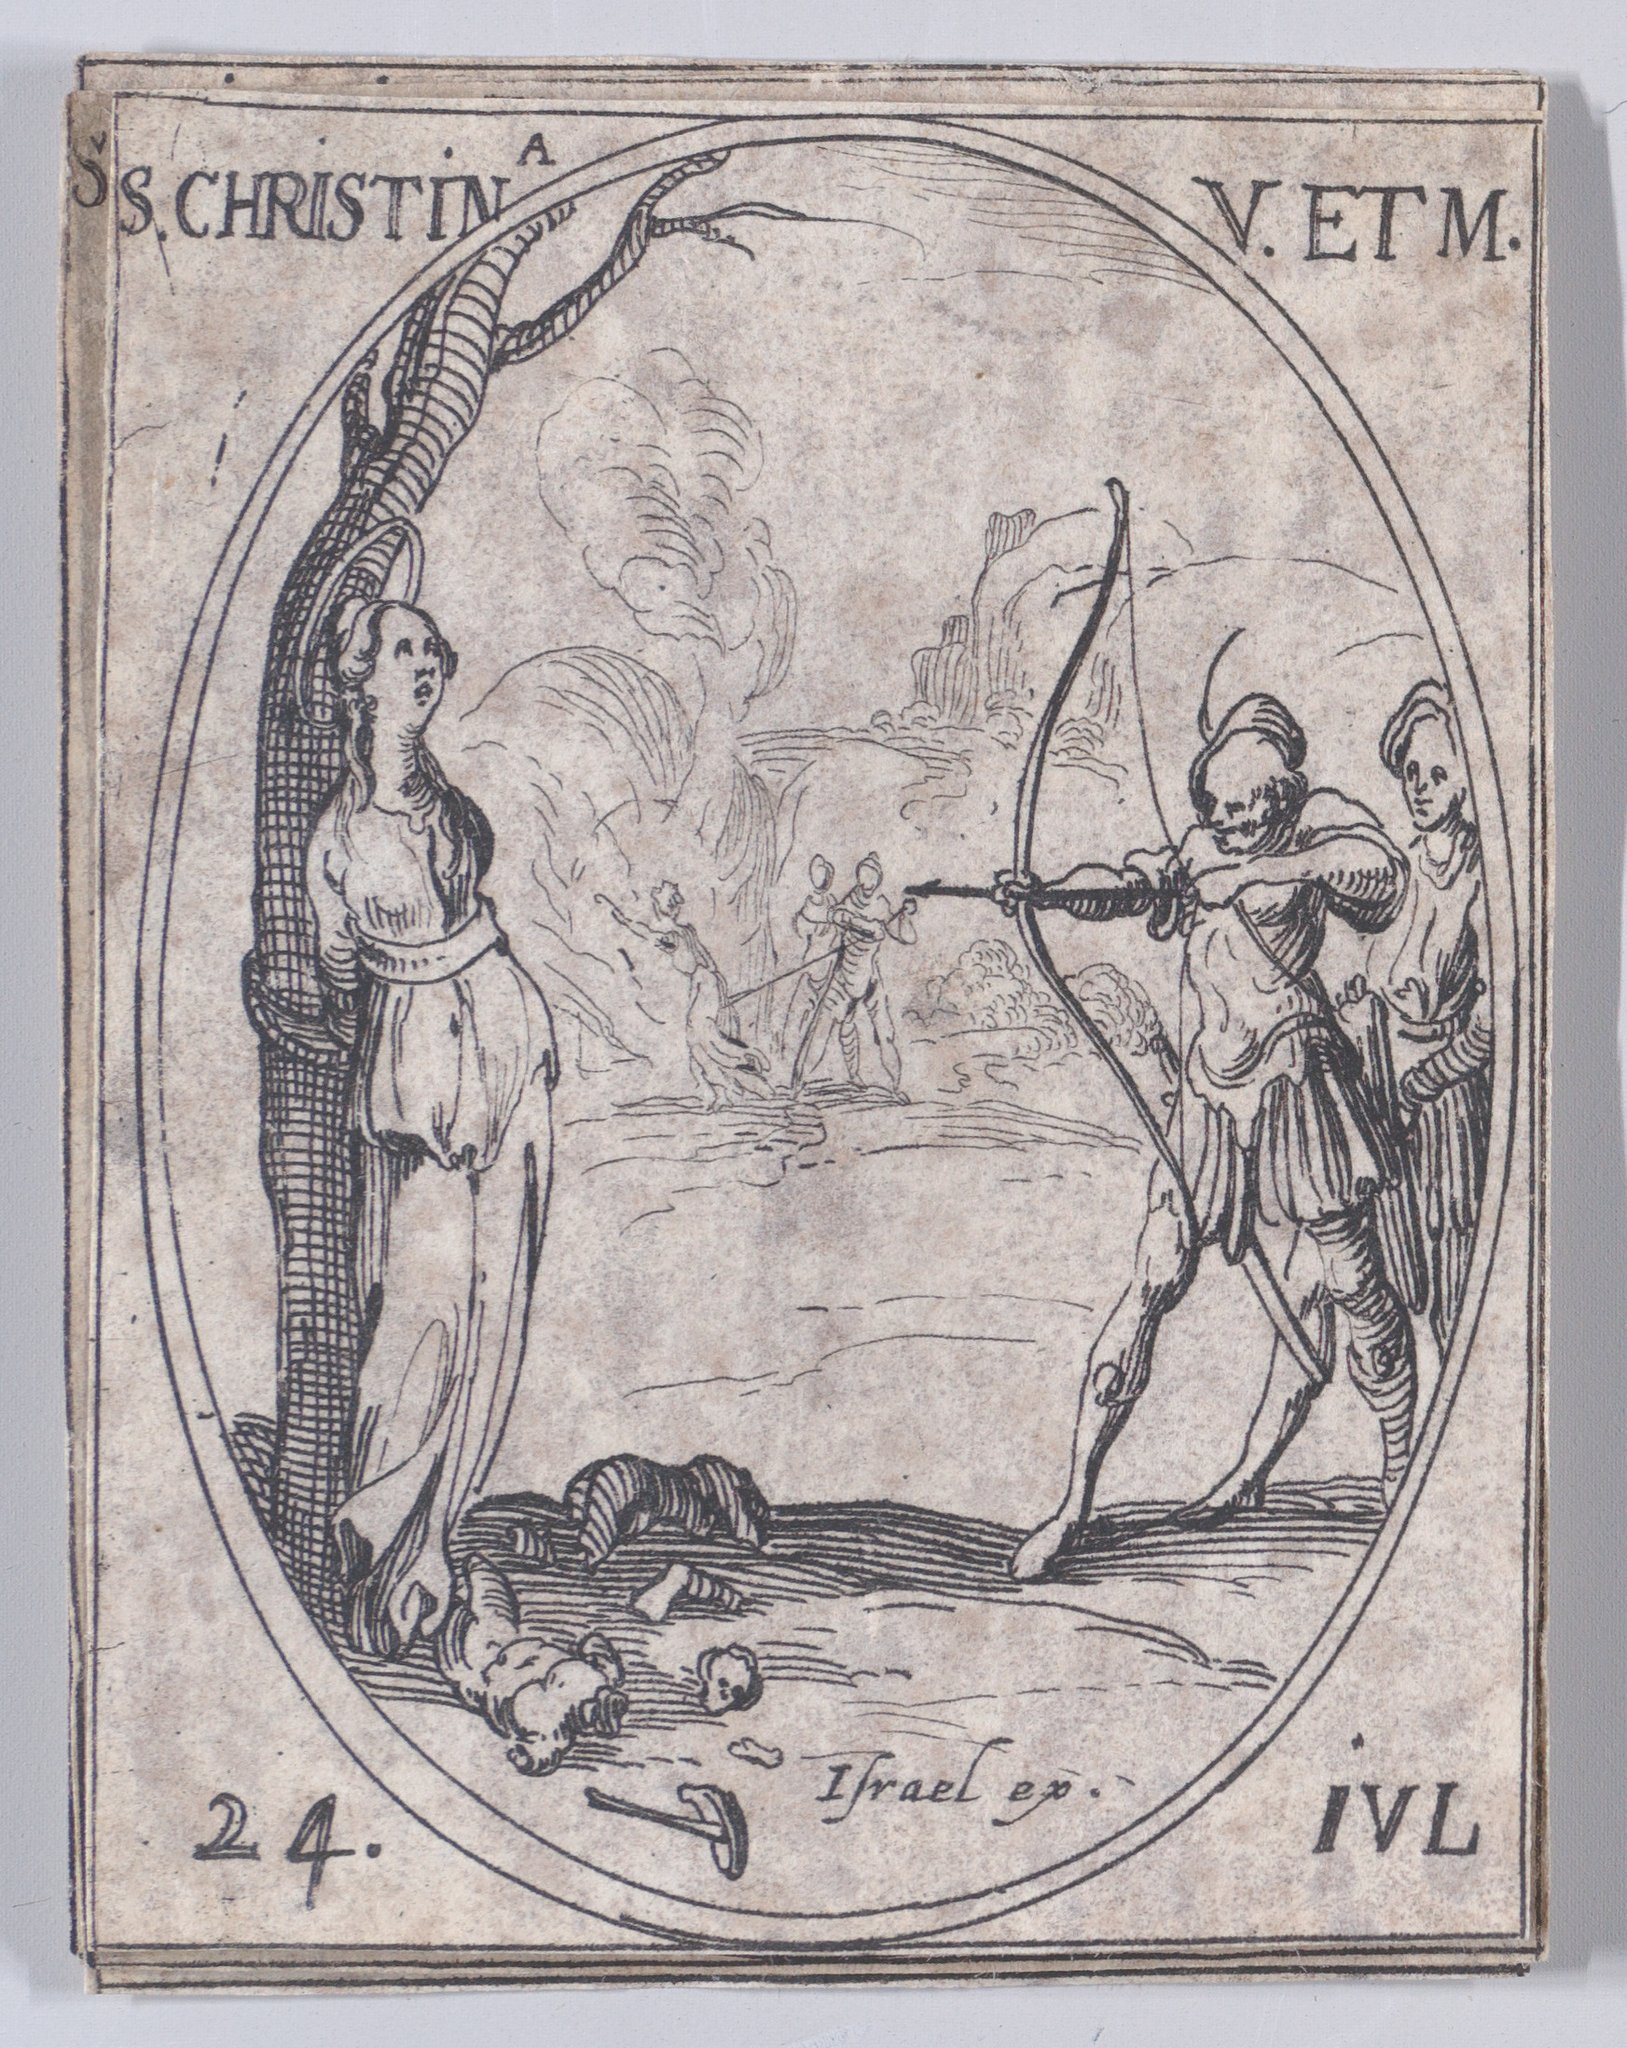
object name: print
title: Ste. Christine, vierge et martyre (St. Christine, Virgin and Martyr), July 24th, from "Les Images De Tous Les Saincts et Saintes de L'Année" (Images of All of the Saints and Religious Events of the Year)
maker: jacques callot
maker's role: artist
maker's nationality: french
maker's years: 1592-1635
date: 1636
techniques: etching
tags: men,women,saints